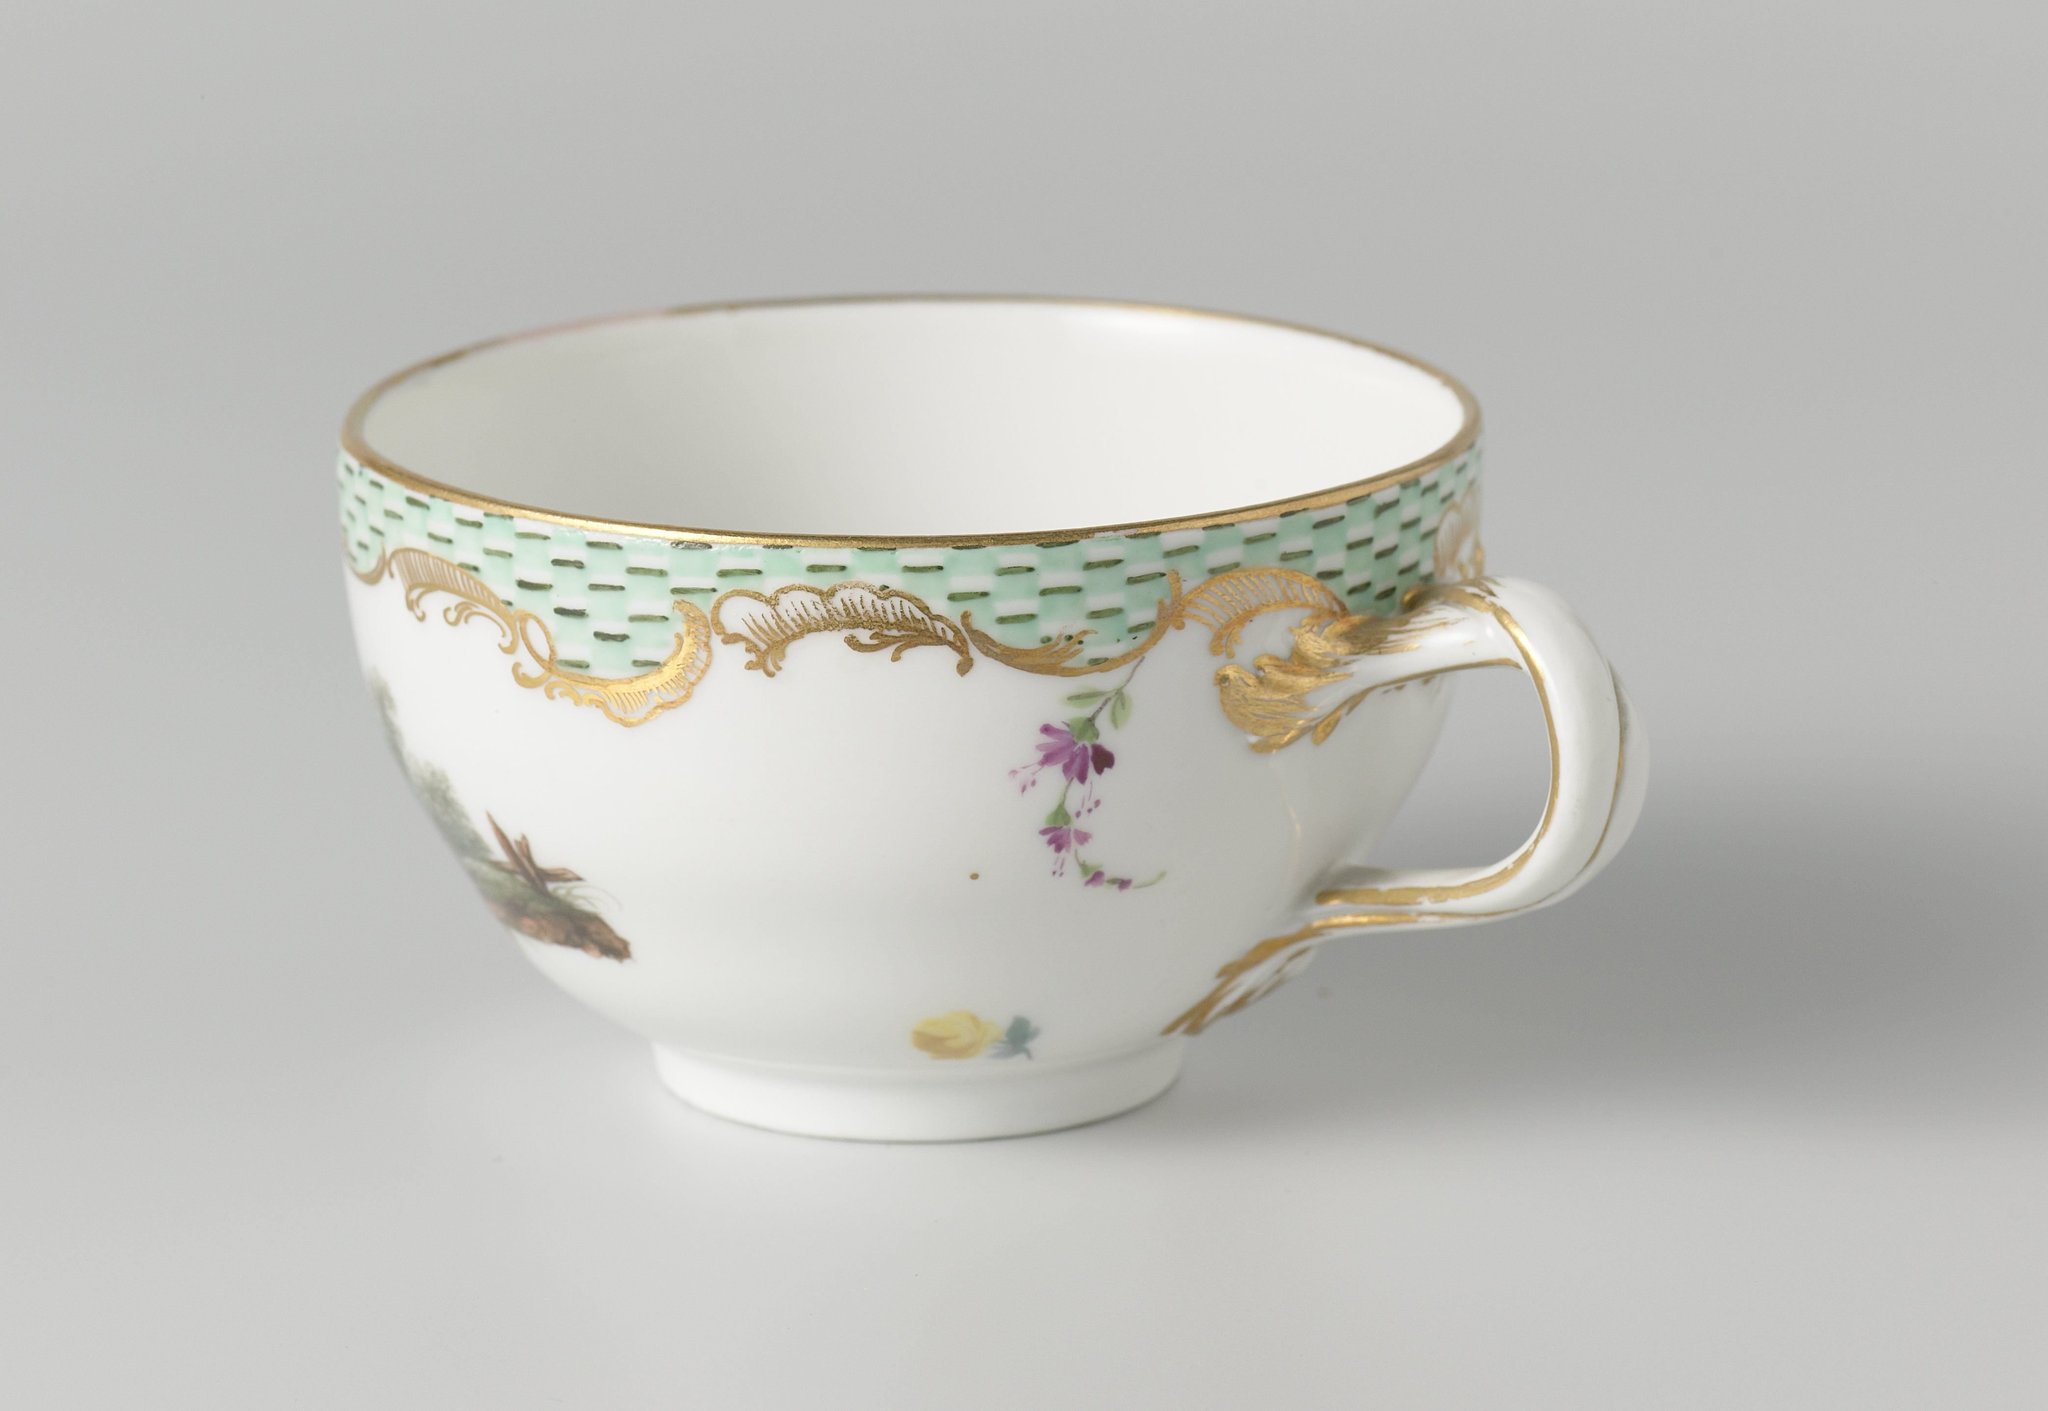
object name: cup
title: Kop, veelkleurig beschilderd met een landschap met figuren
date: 1777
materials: porcelain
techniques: painted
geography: meissen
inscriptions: mold mark: ‘15’, factory mark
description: Lage kop met oor, van beschilderd porselein. De kop is beschilderd met landschappen waarin figuren en langs de rand een brede strook groen vlechtwerk. De kop is gemerkt.